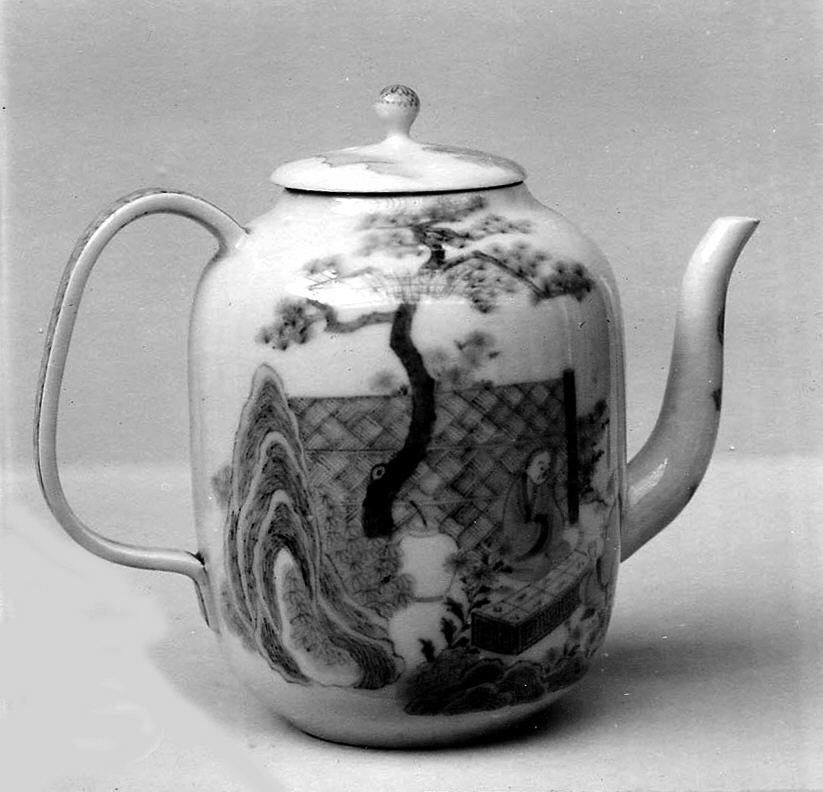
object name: covered water pot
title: Water Pot with Chinese Figures in a Landscape Design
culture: japanese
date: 1767-1800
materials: porcelain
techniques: underglaze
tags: men,trees